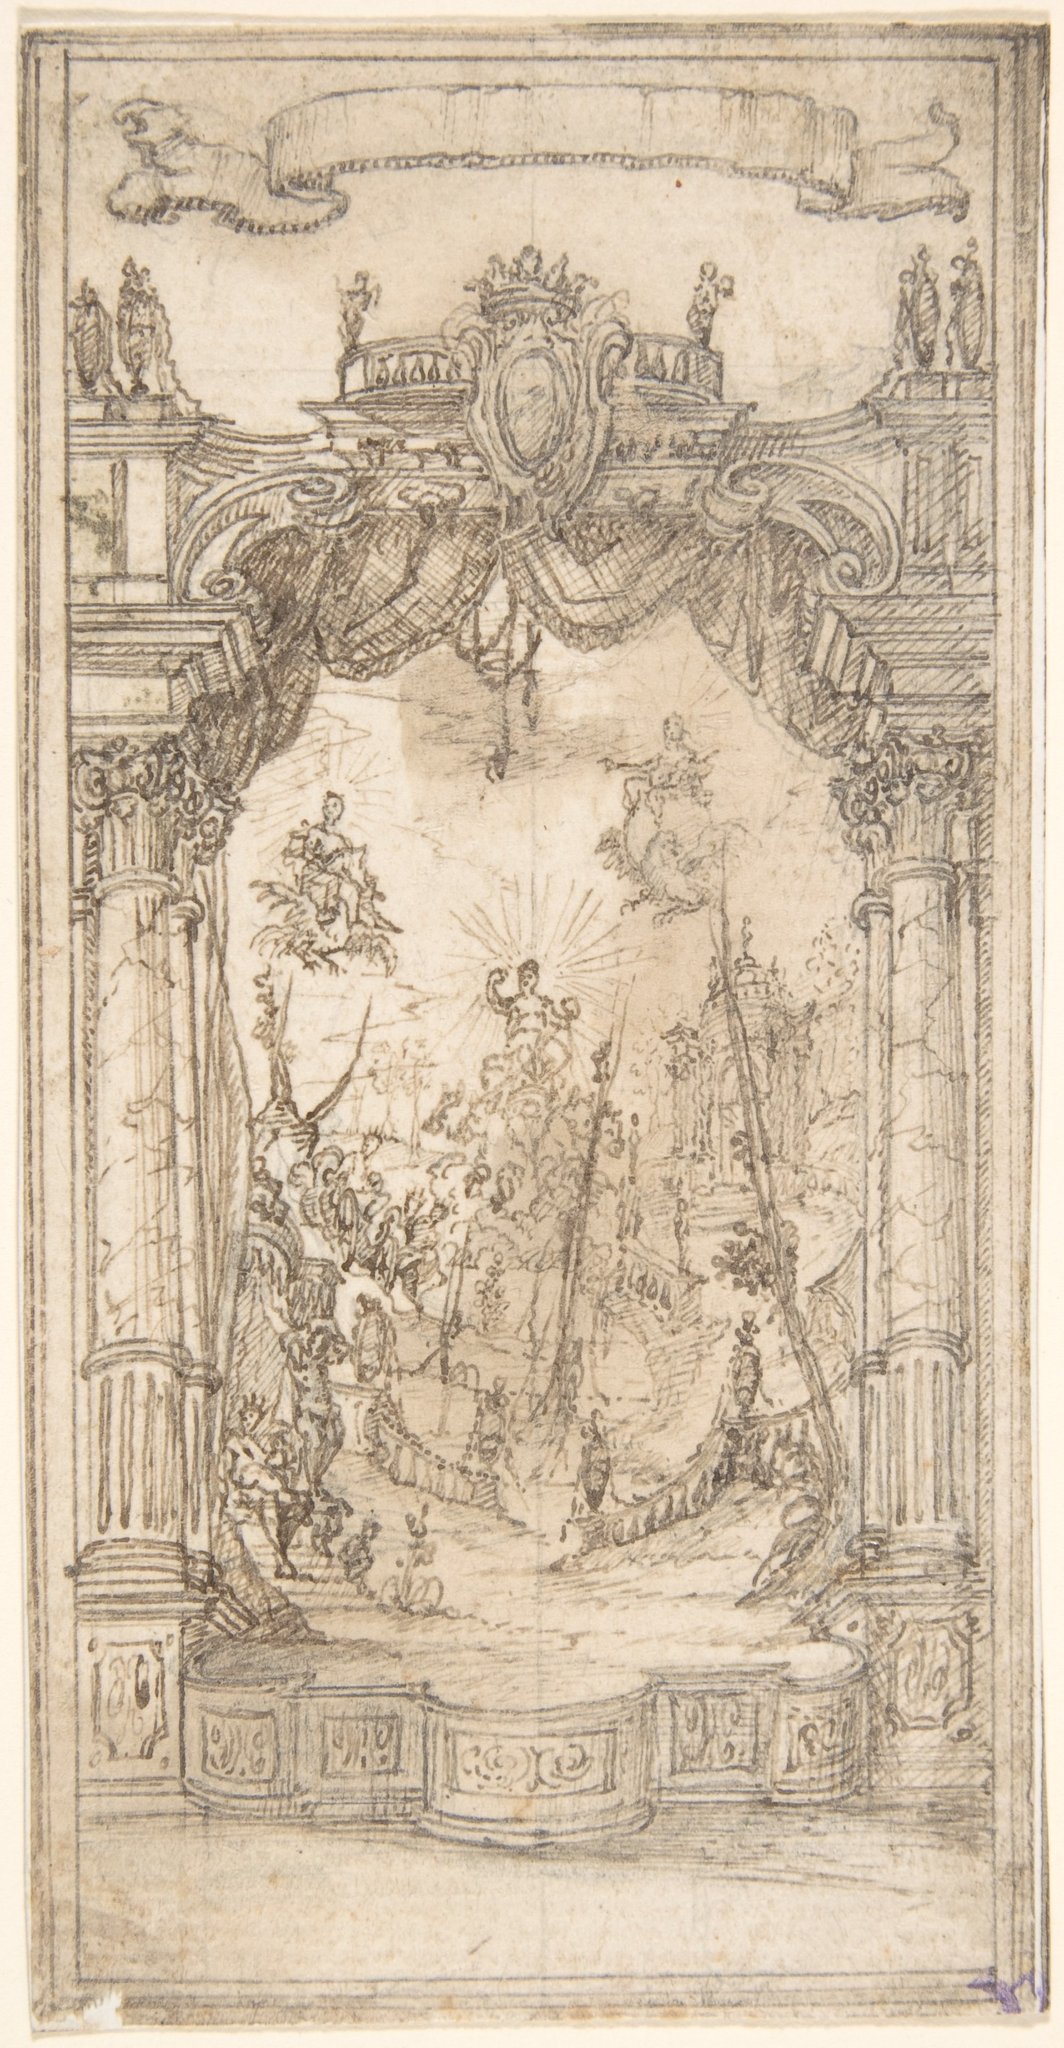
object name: drawing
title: Design for a Stage Set or Illustration in a Fête Book with a Blank Scroll Above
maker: anonymous, italian, 18th century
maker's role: artist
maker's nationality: italian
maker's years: 1700-1800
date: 1701-1800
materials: graphite, ink, lead, paper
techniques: pen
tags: stage design